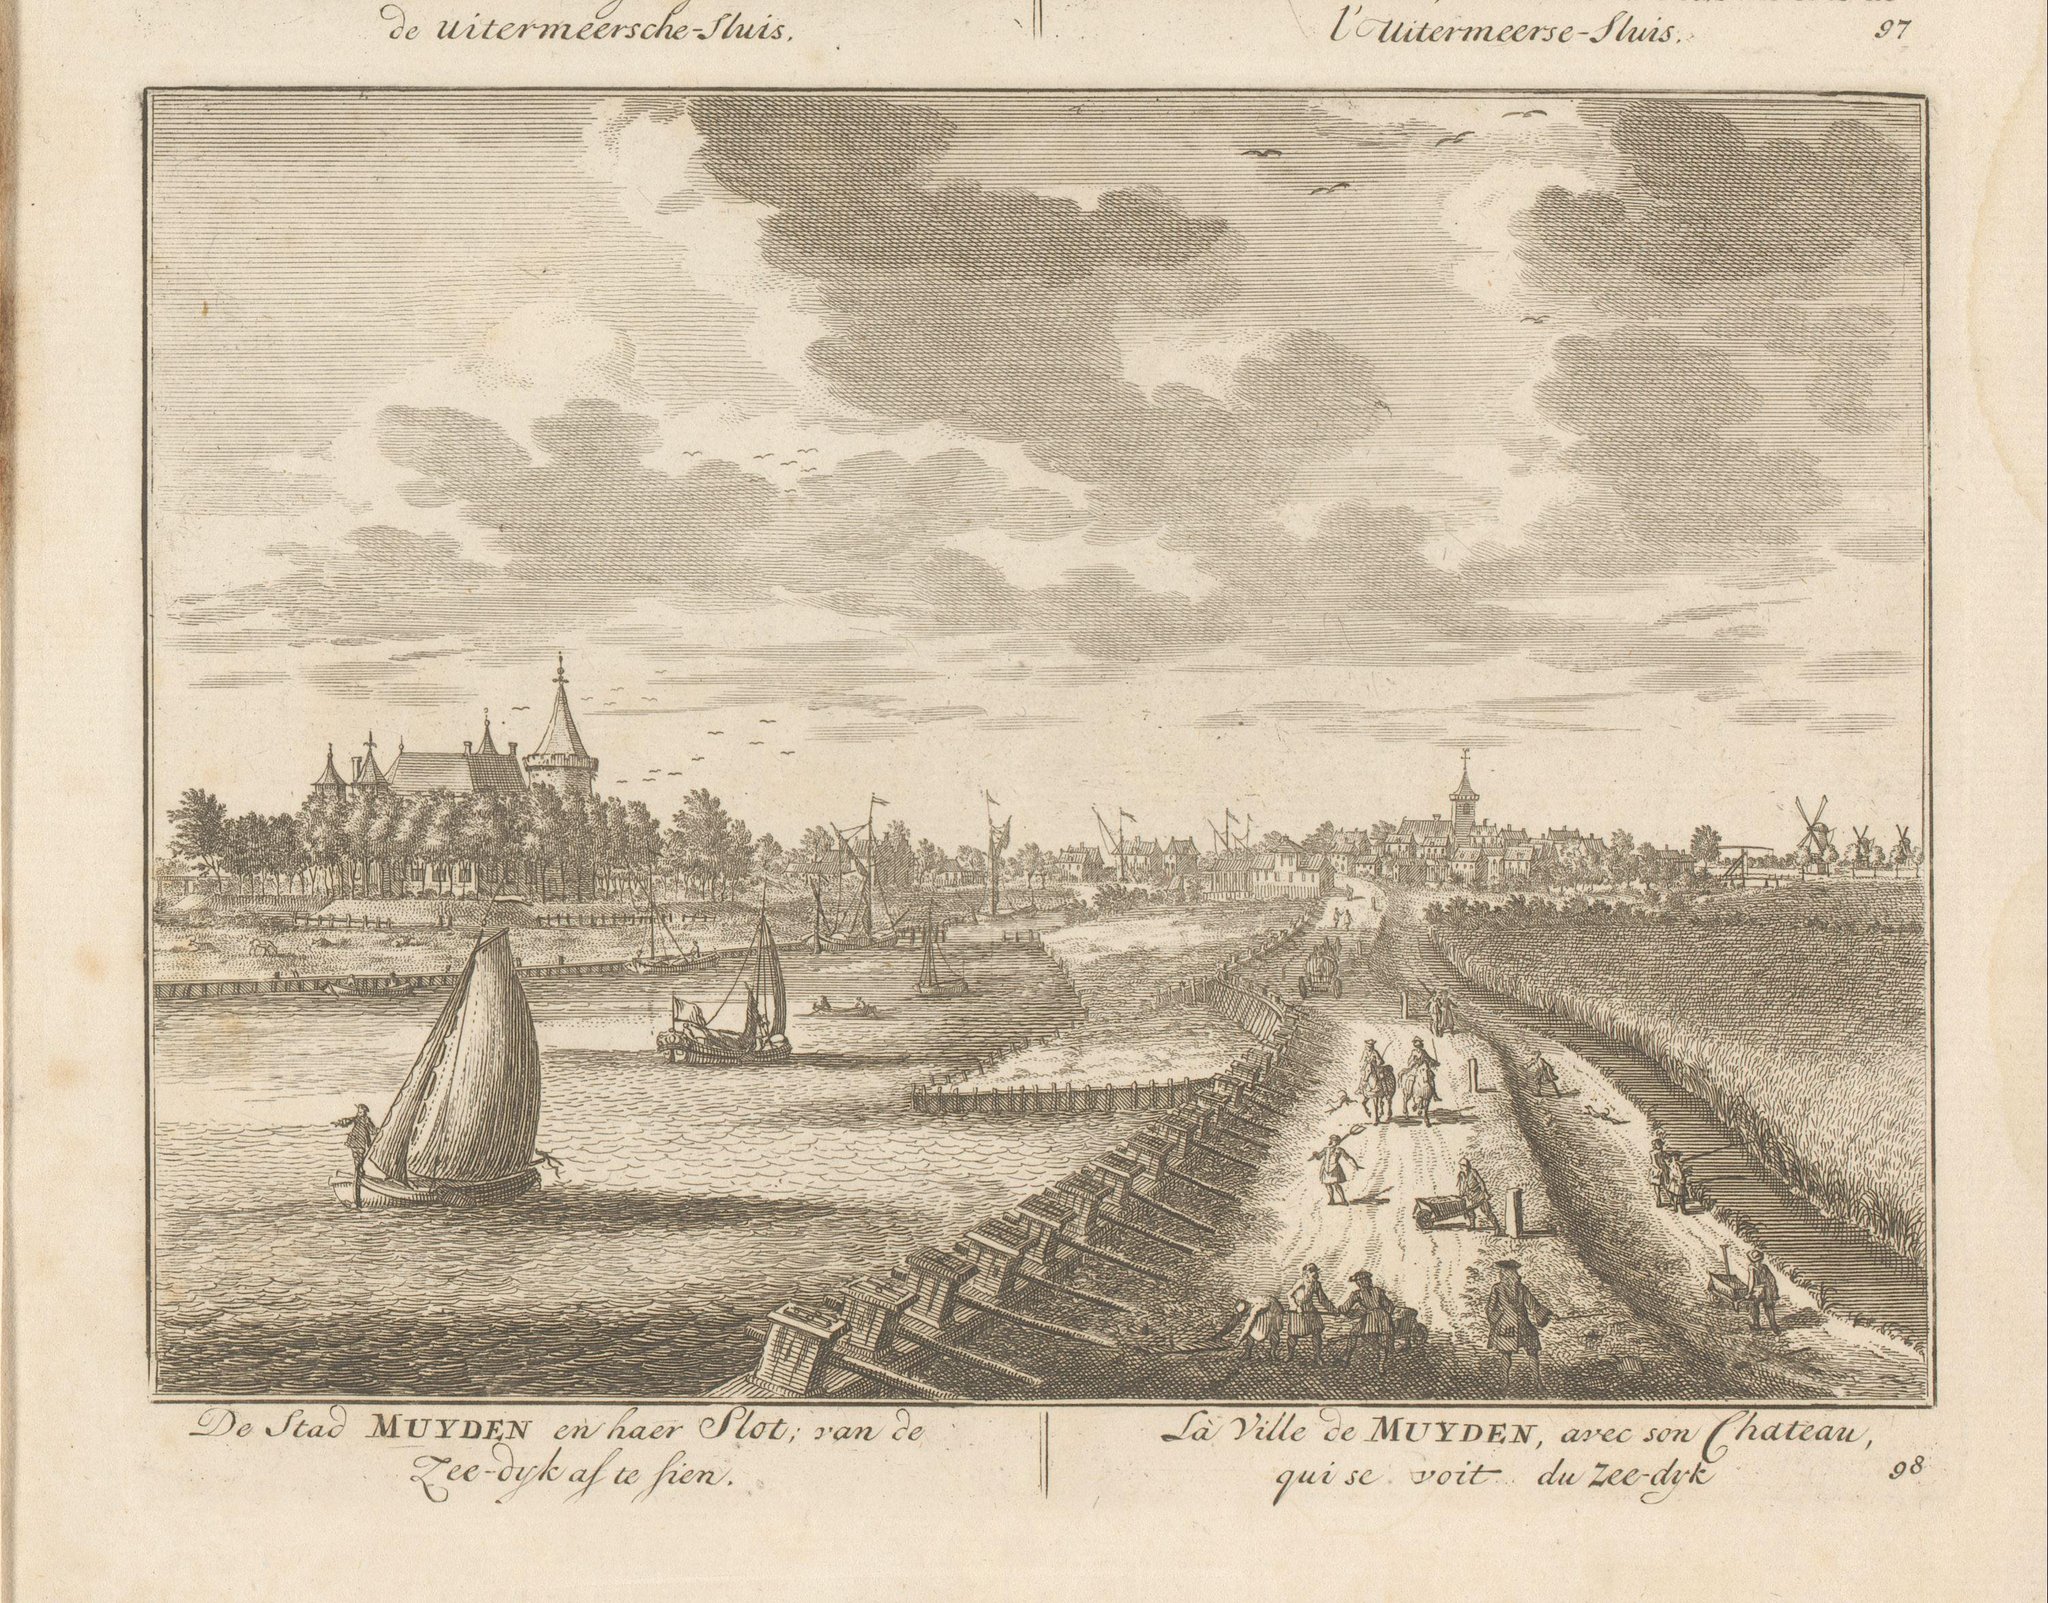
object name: book illustration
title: Gezicht op het Muiderslot aan de Vecht en Muiden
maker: daniël stopendaal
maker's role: print maker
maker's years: 1672-1726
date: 1790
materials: paper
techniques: engraving, etching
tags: prospect of village, silhouette of village, castle, river (+ landscape with figures, staffage), vecht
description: Prent gebruikt in: Leth, Andries de. De zegepraalende Vecht, vertoonende verscheidene gesichten van lustplaatsen, heeren huysen en dorpen, beginnende van Uitrecht en met Muyden besluytende (...). Amsterdam: Weduwe Nicolaus Visscher, 1719. Prent ook gebruikt in: Brouërius van Nidek, Matthaeus. De Vechtstroom, van Utrecht tot Muiden (...). Amsterdam: H. Gartman, W. Vermandel en J.W. Smit, 1790.